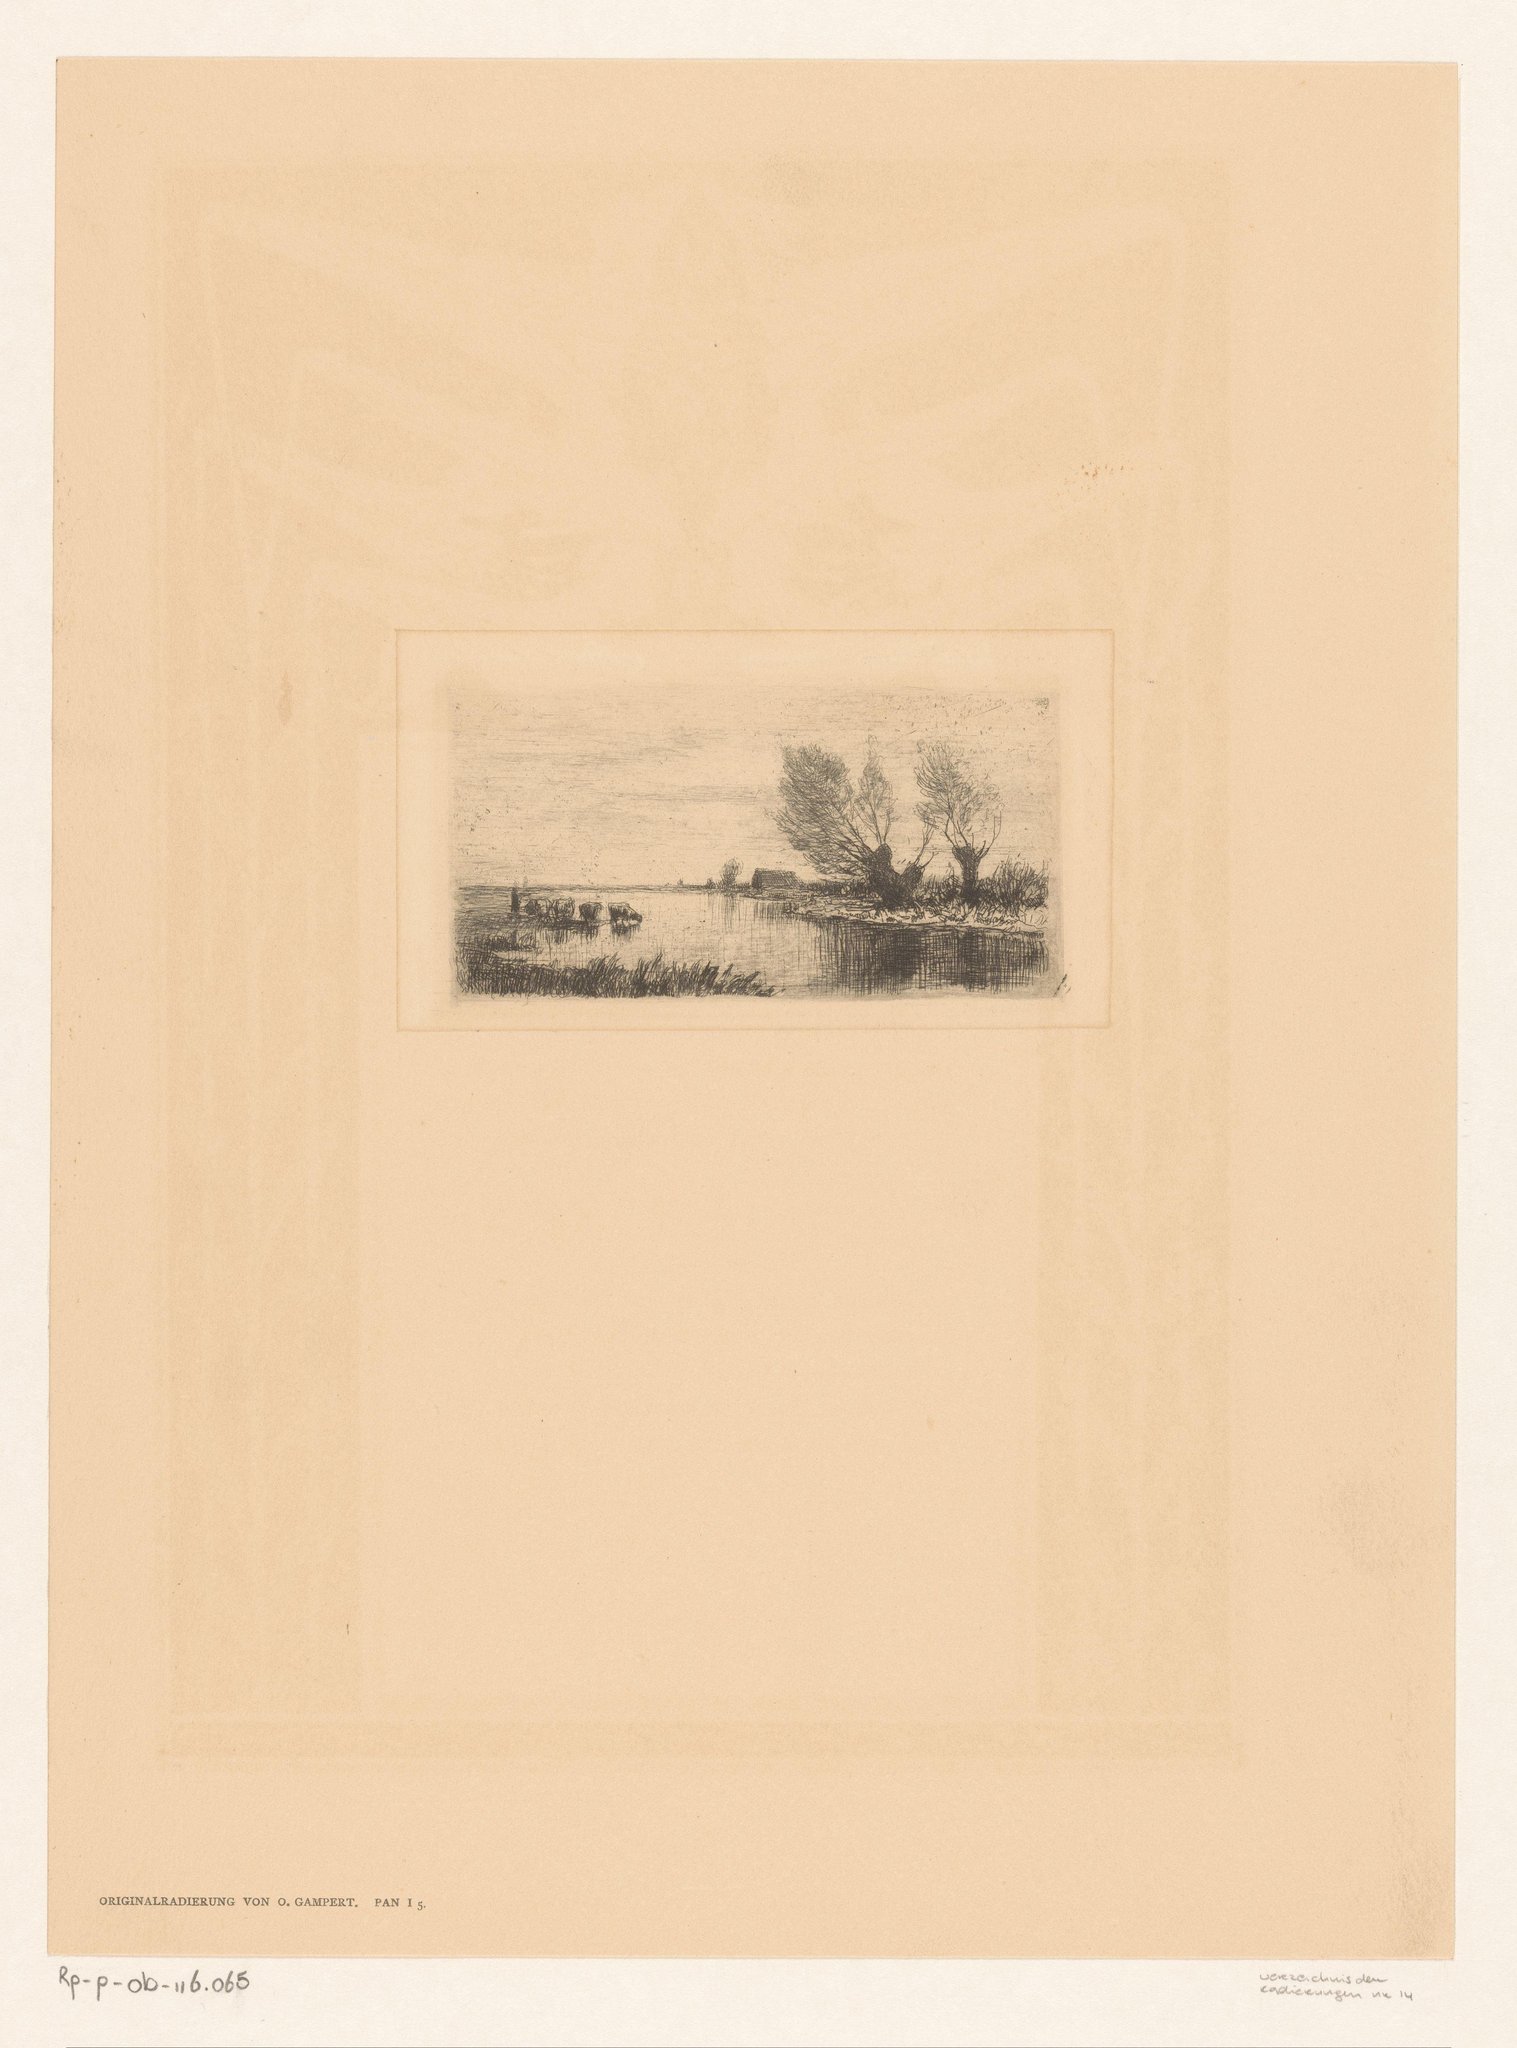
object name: print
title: Rivierlandschap met knotwilgen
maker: otto gampert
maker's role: print maker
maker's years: 1842-1897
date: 1892-1905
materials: paper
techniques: etching, intaglio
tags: trees: willow, river (+ landscape with figures, staffage)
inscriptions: collector's mark: Lugt 2228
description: Prent gebruikt voor: Verein für Original-Radierung in München. München: Verein für Original-Radierung, [1892-1905].